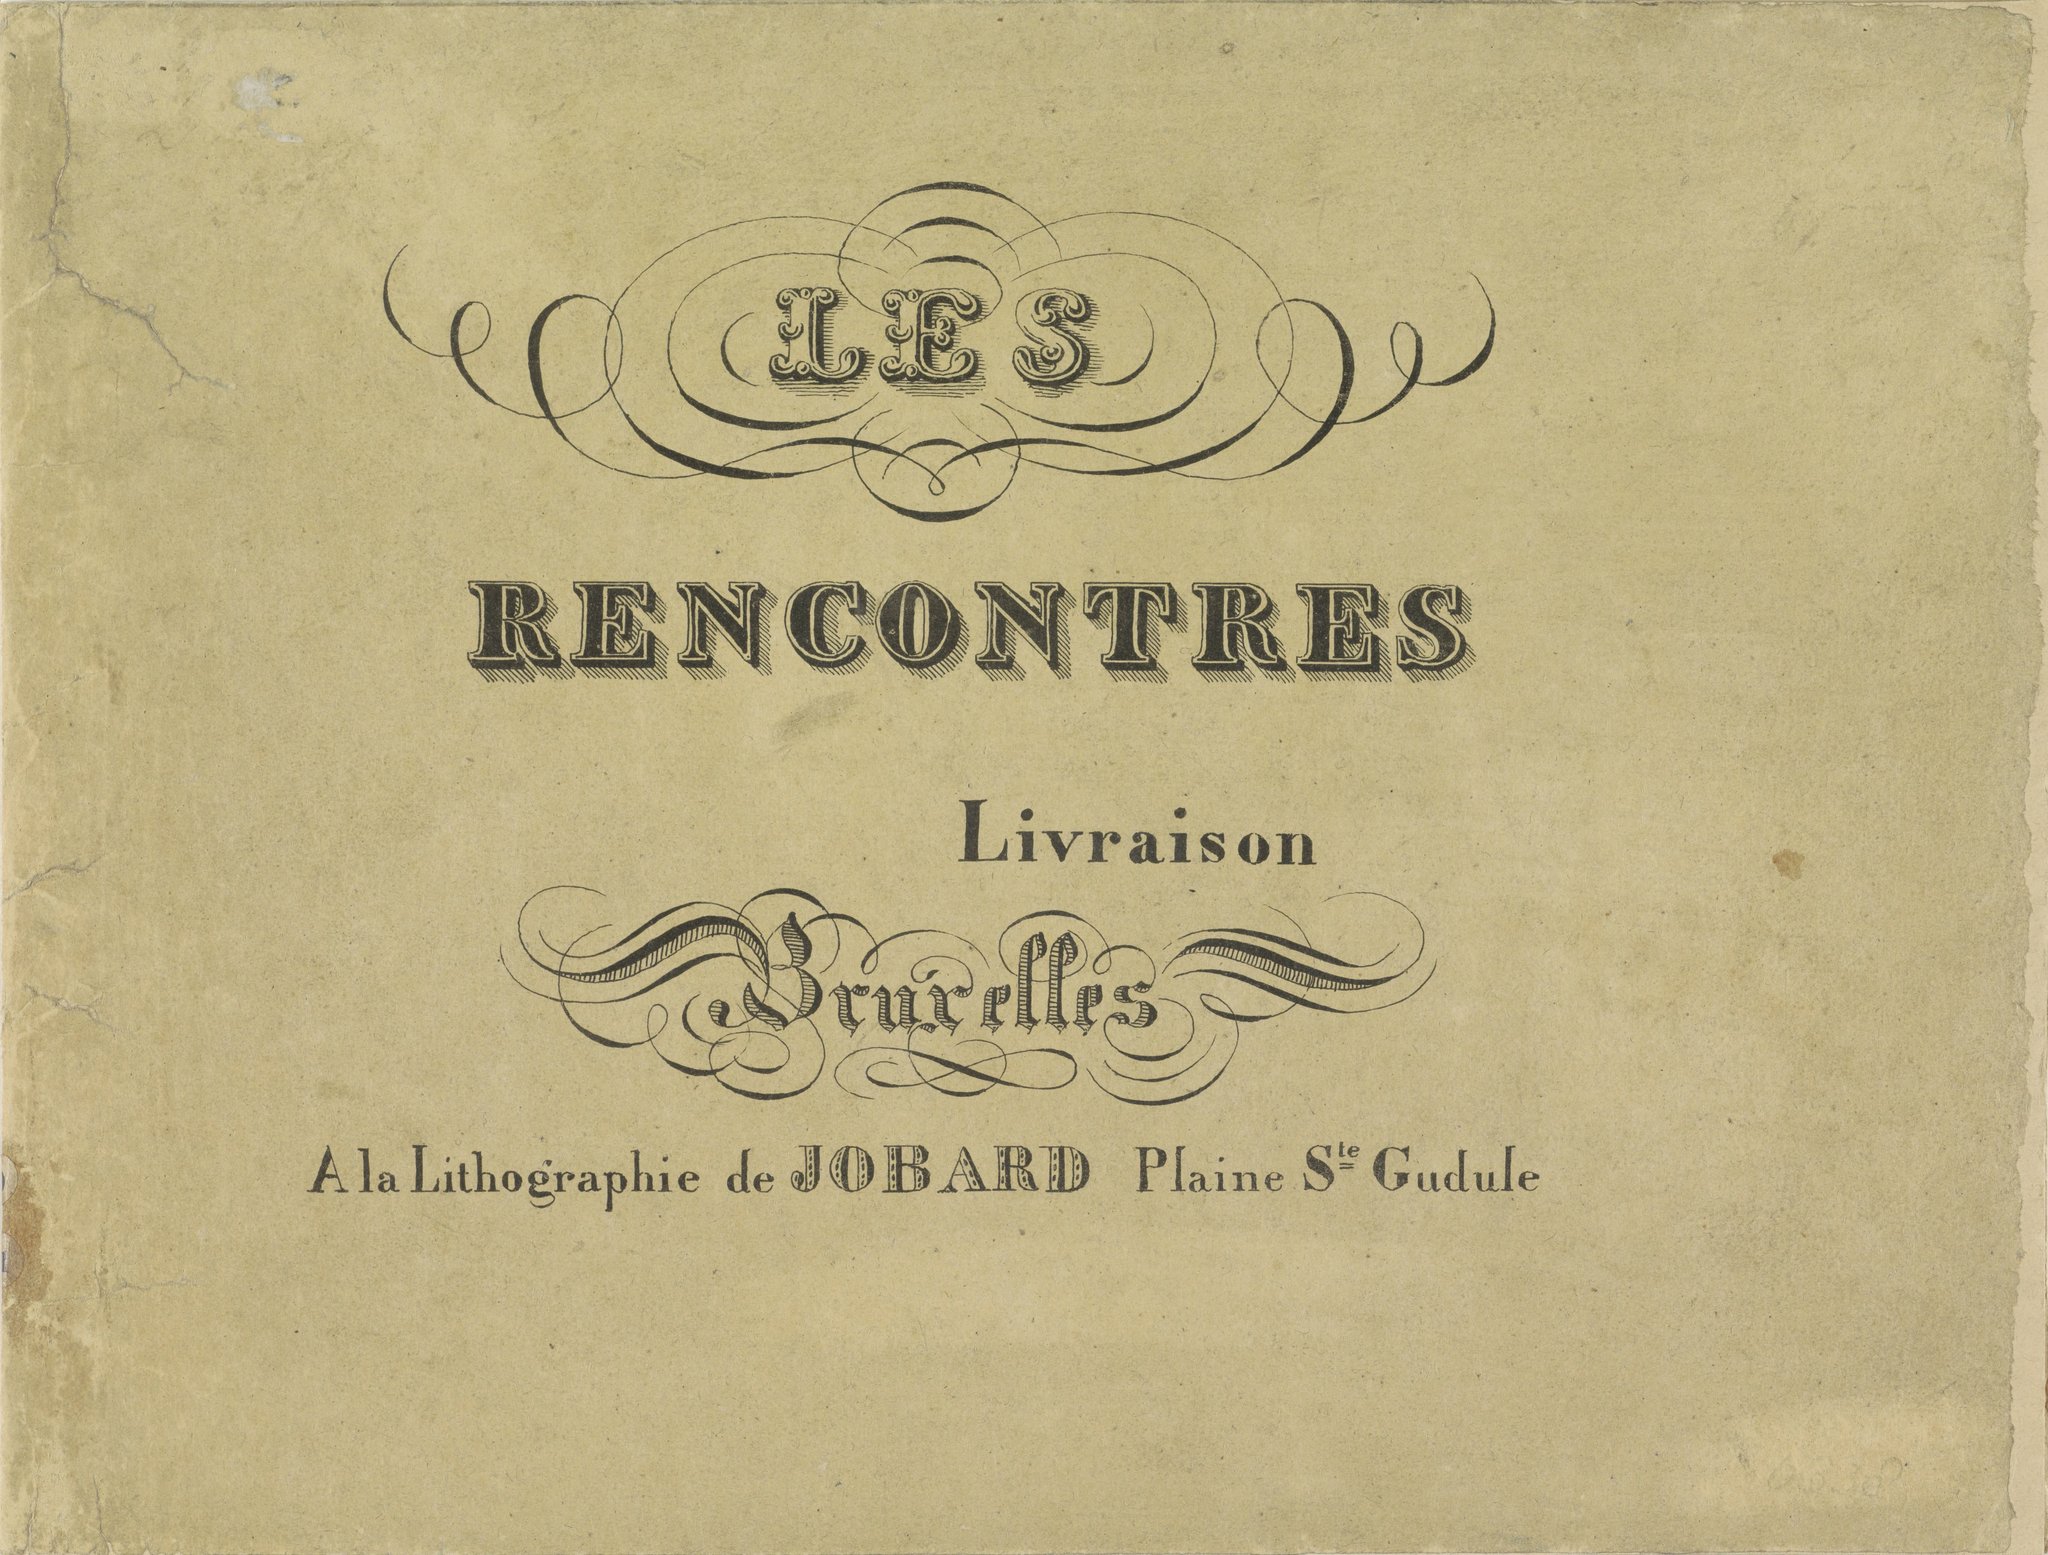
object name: wrapper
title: Les rencontres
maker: jean baptiste ambroise marcellin jobard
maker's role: print maker, publisher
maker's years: 1792-1861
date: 1829-1830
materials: paper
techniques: lithograph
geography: brussels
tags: the hague, william i of the netherlands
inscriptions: collector's mark: Lugt 2228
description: De serie werd vervaardigd als tegengeluid tegenover de voortdurende aanvallen in de Belgische pers en om de publieke opinie in de Zuidelijke Nederlanden gunstig te stemmen ten opzichte van koning Willem I.